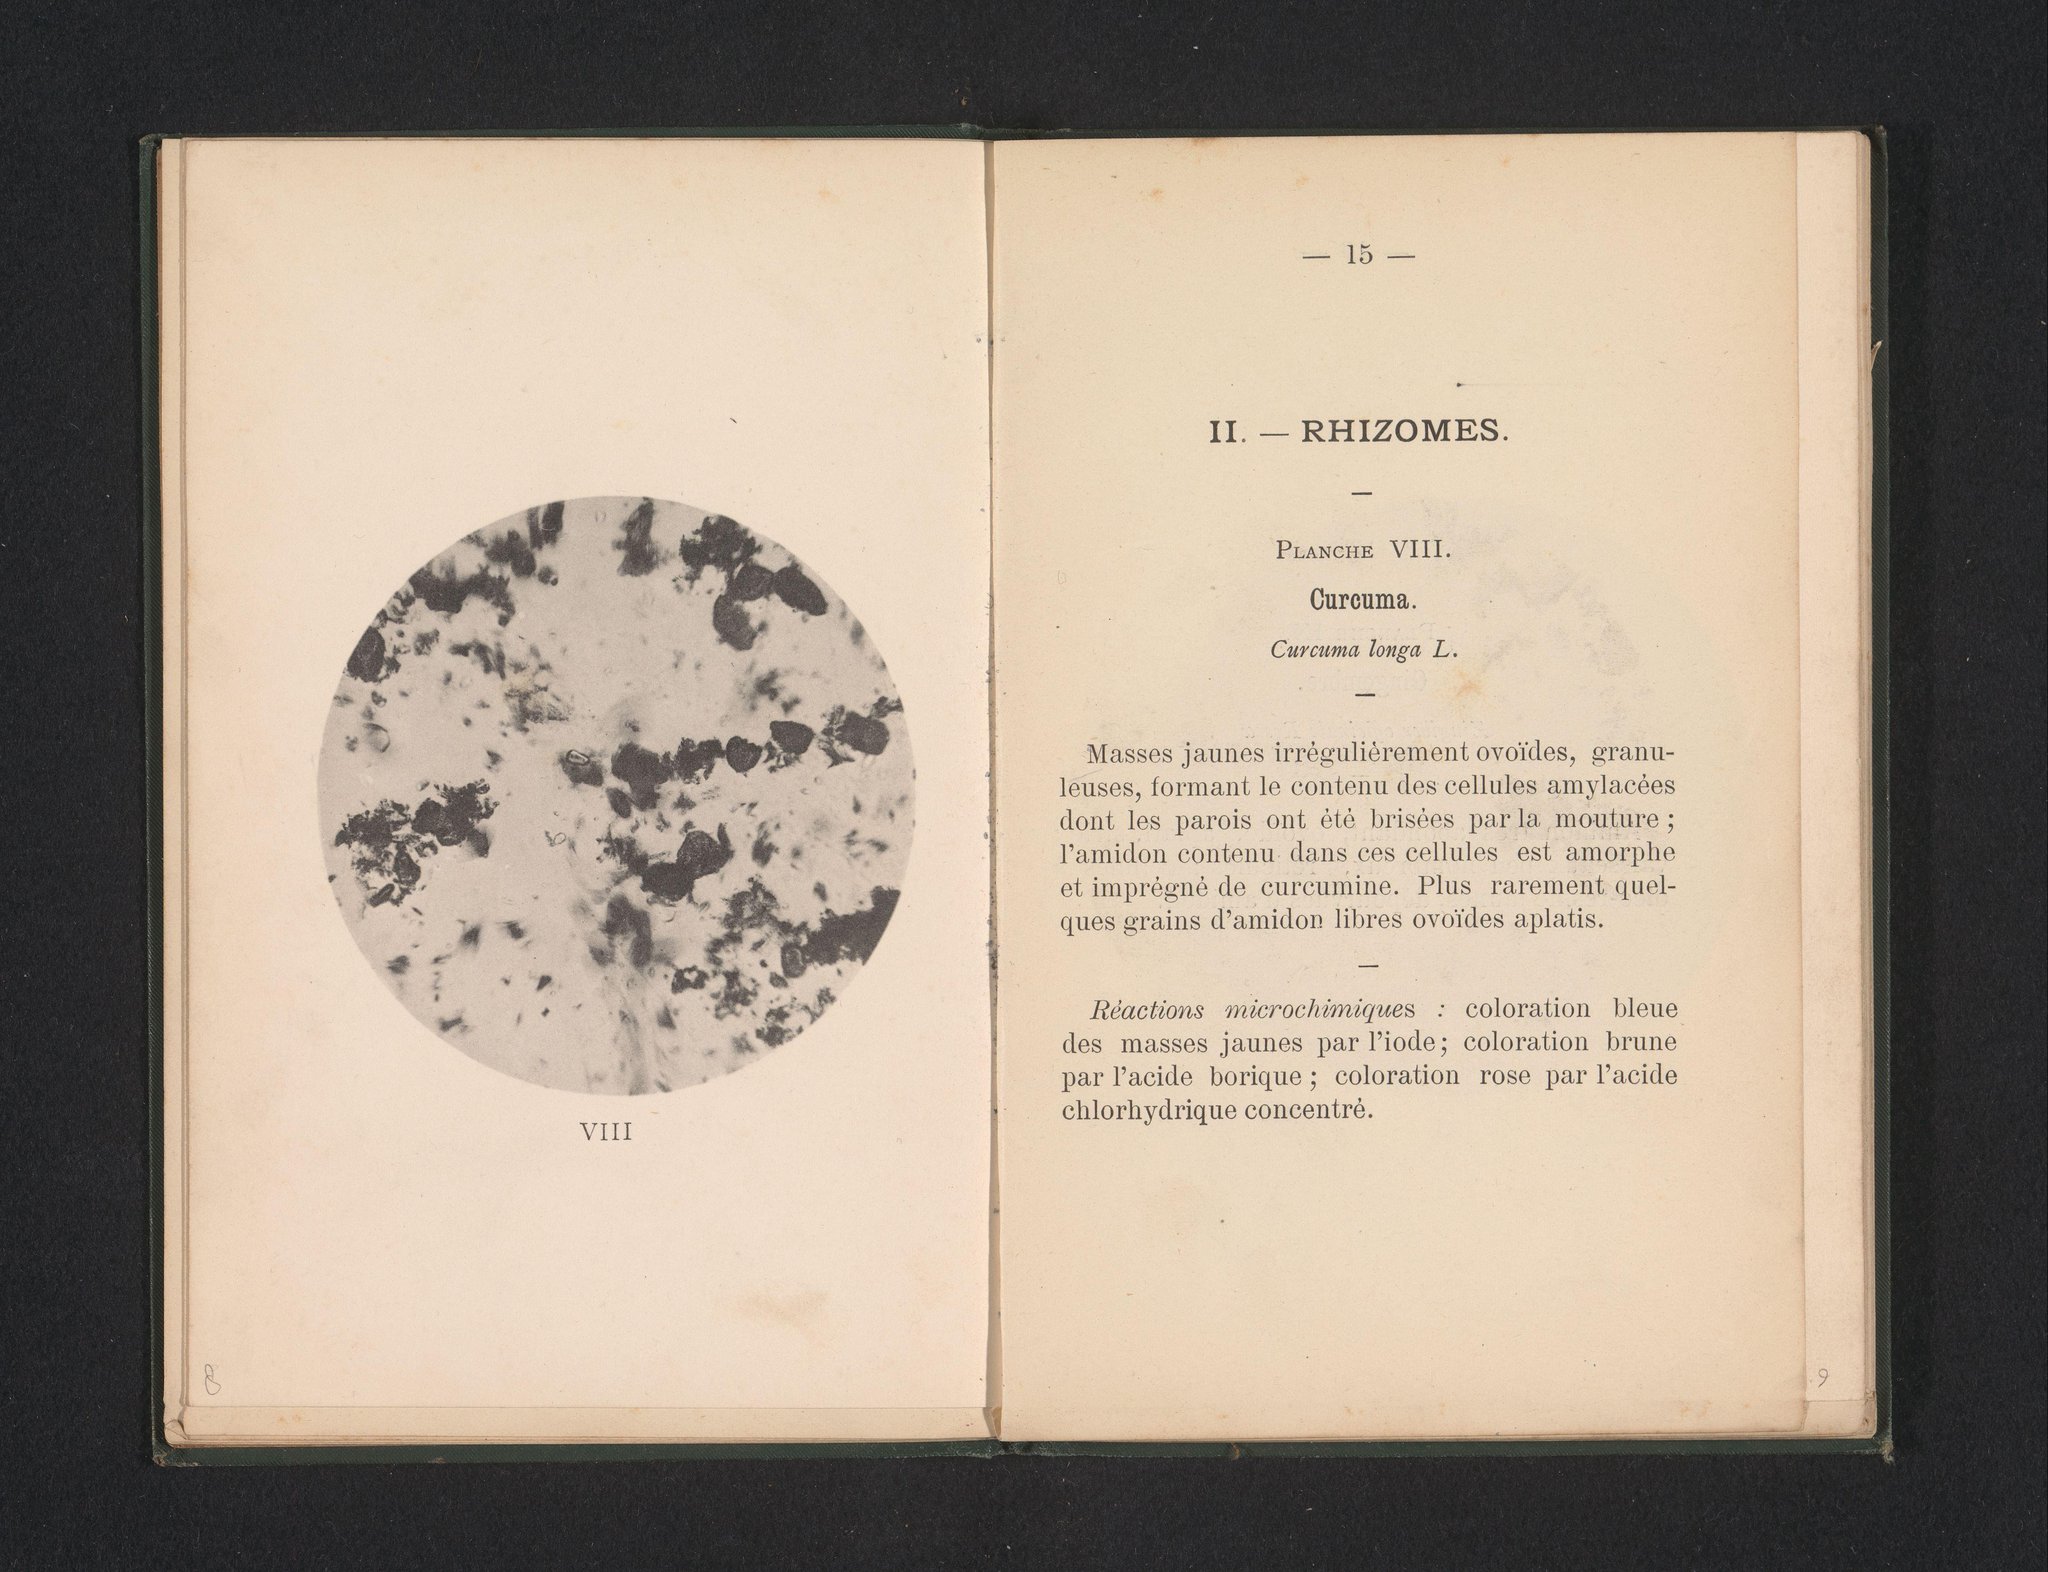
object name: photomechanical print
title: Microscopische weergave van kurkuma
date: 1891-1896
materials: paper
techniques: photograph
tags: microscope (+ scientific research)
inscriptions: number: ‘VIII’